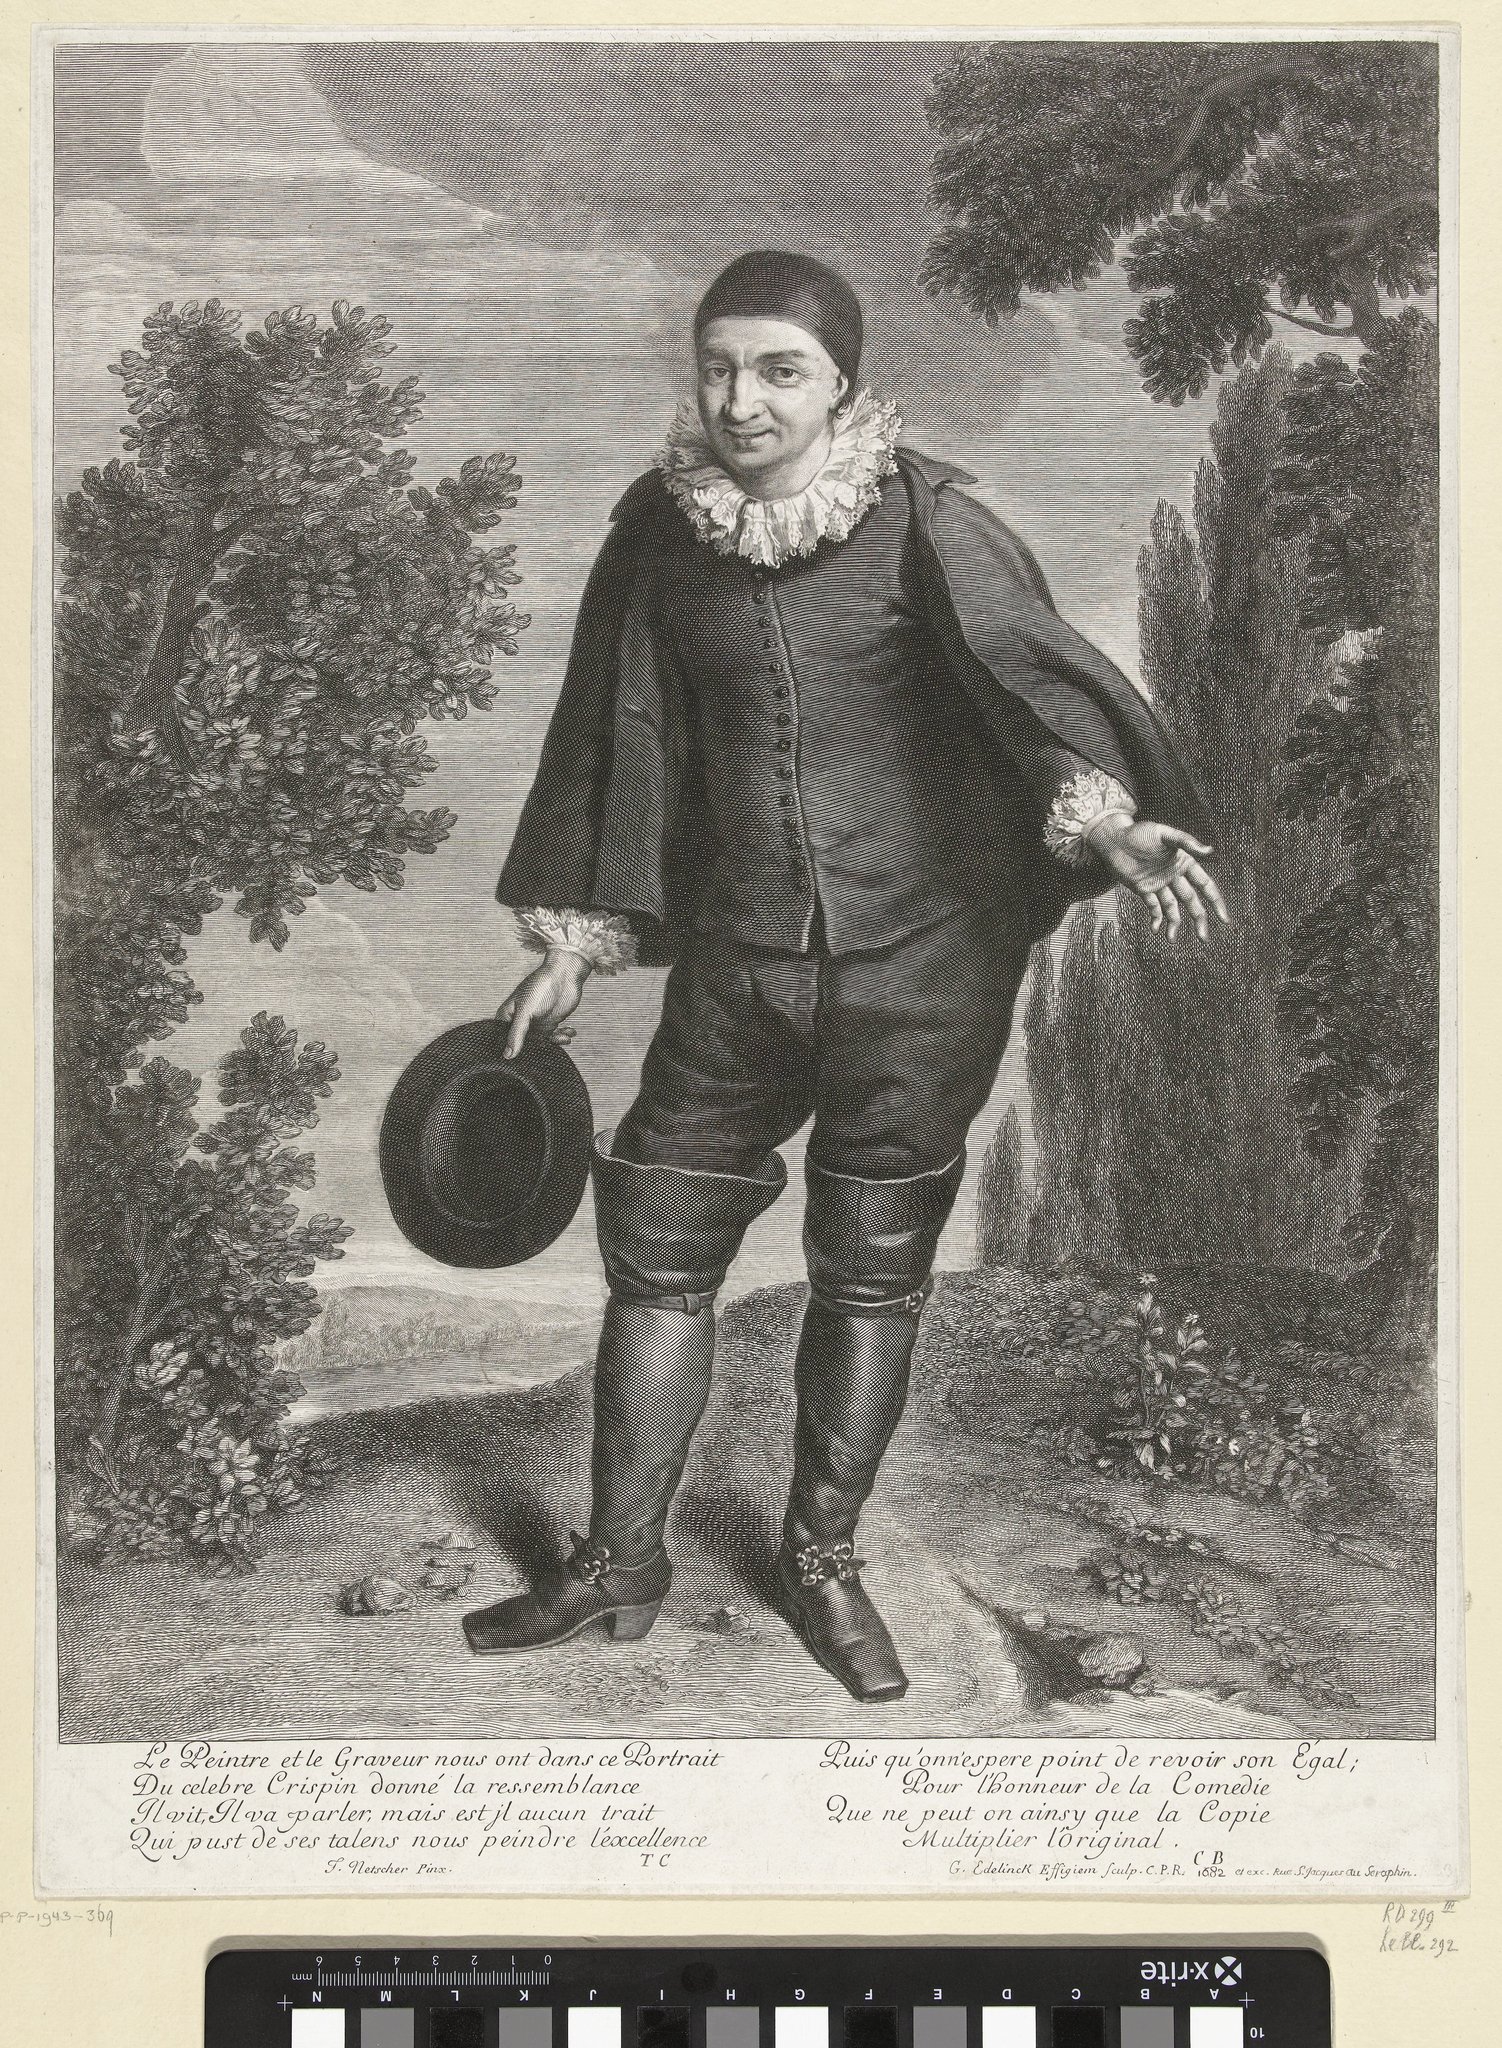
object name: print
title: Portret van Raymond Poisson als Krispijn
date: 1682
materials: paper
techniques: engraving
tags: acteur, raymond poisson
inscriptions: collector's mark: Lugt 2760, collector's mark: Lugt 2228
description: De zeventiende-eeuwse Franse acteur Raymond Poisson, ook wel bekend als Belleroche, ten voeten uit afgebeeld als zijn meest bekende personnage, Krispijn. Onderaan een Frans vers in twee keer vier regels.